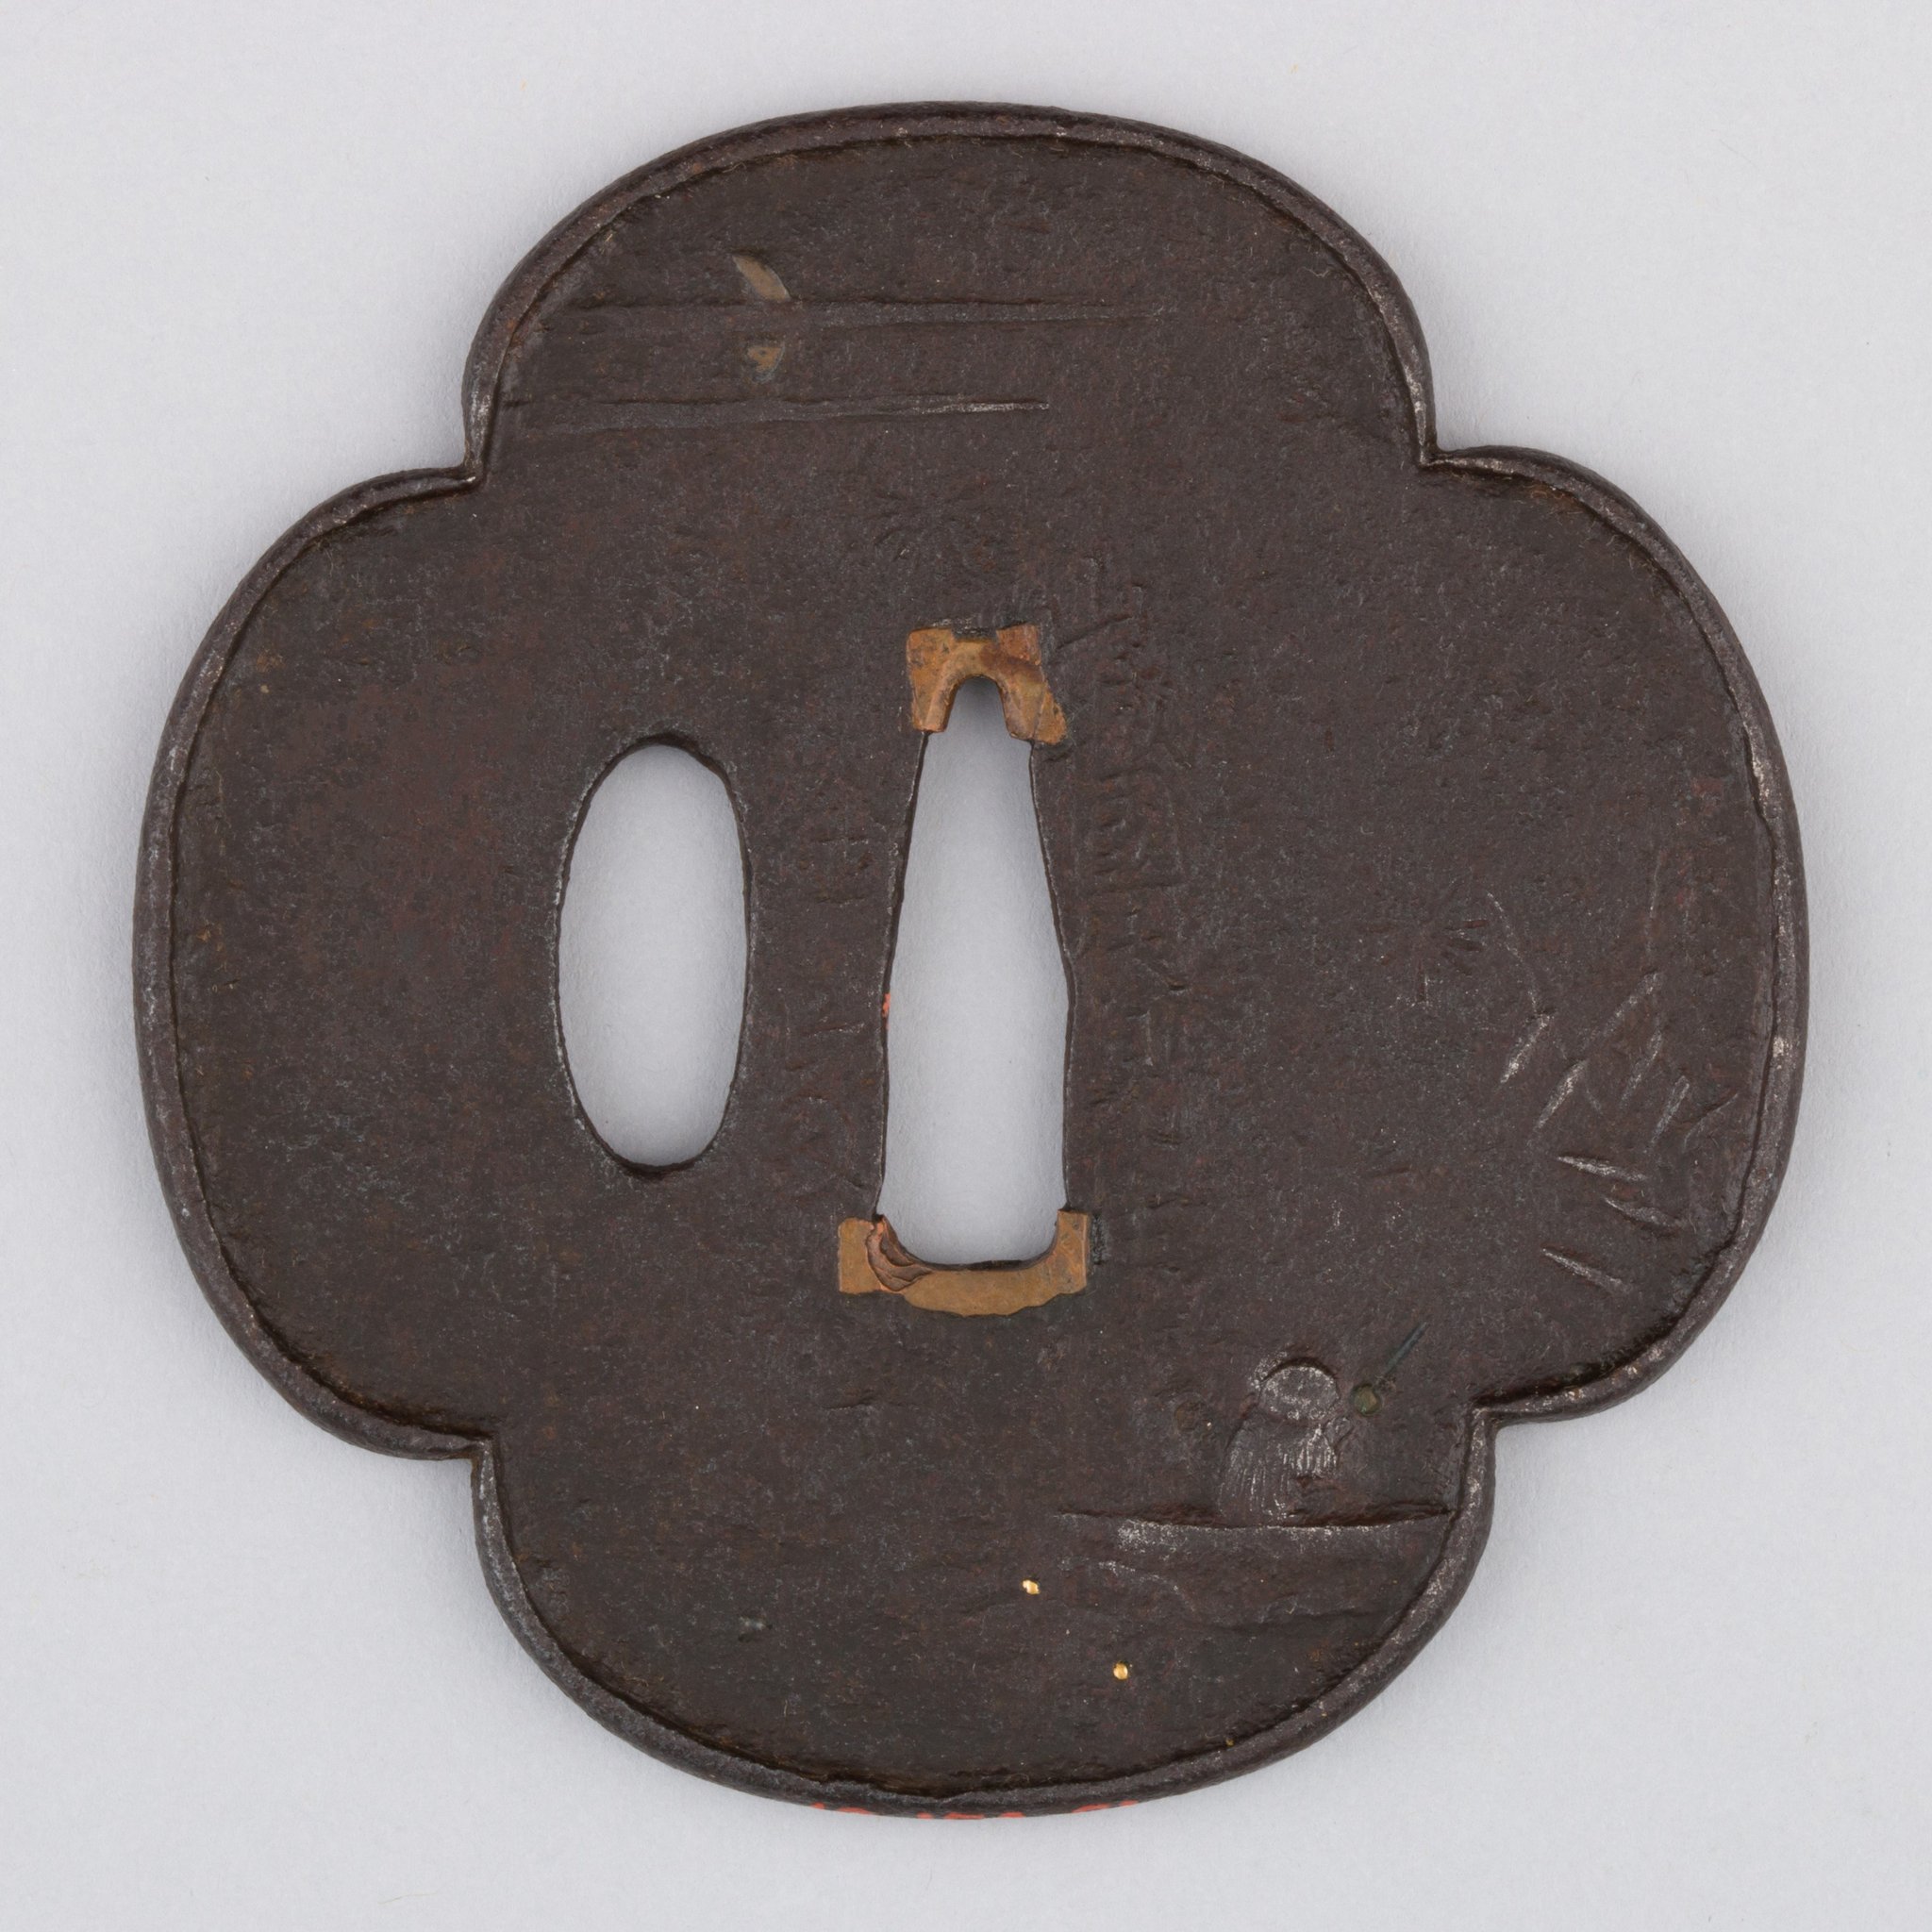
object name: sword guard tsuba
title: Sword Guard (Tsuba)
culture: japanese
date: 1615-1868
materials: copper, iron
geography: japan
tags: human figures,boats